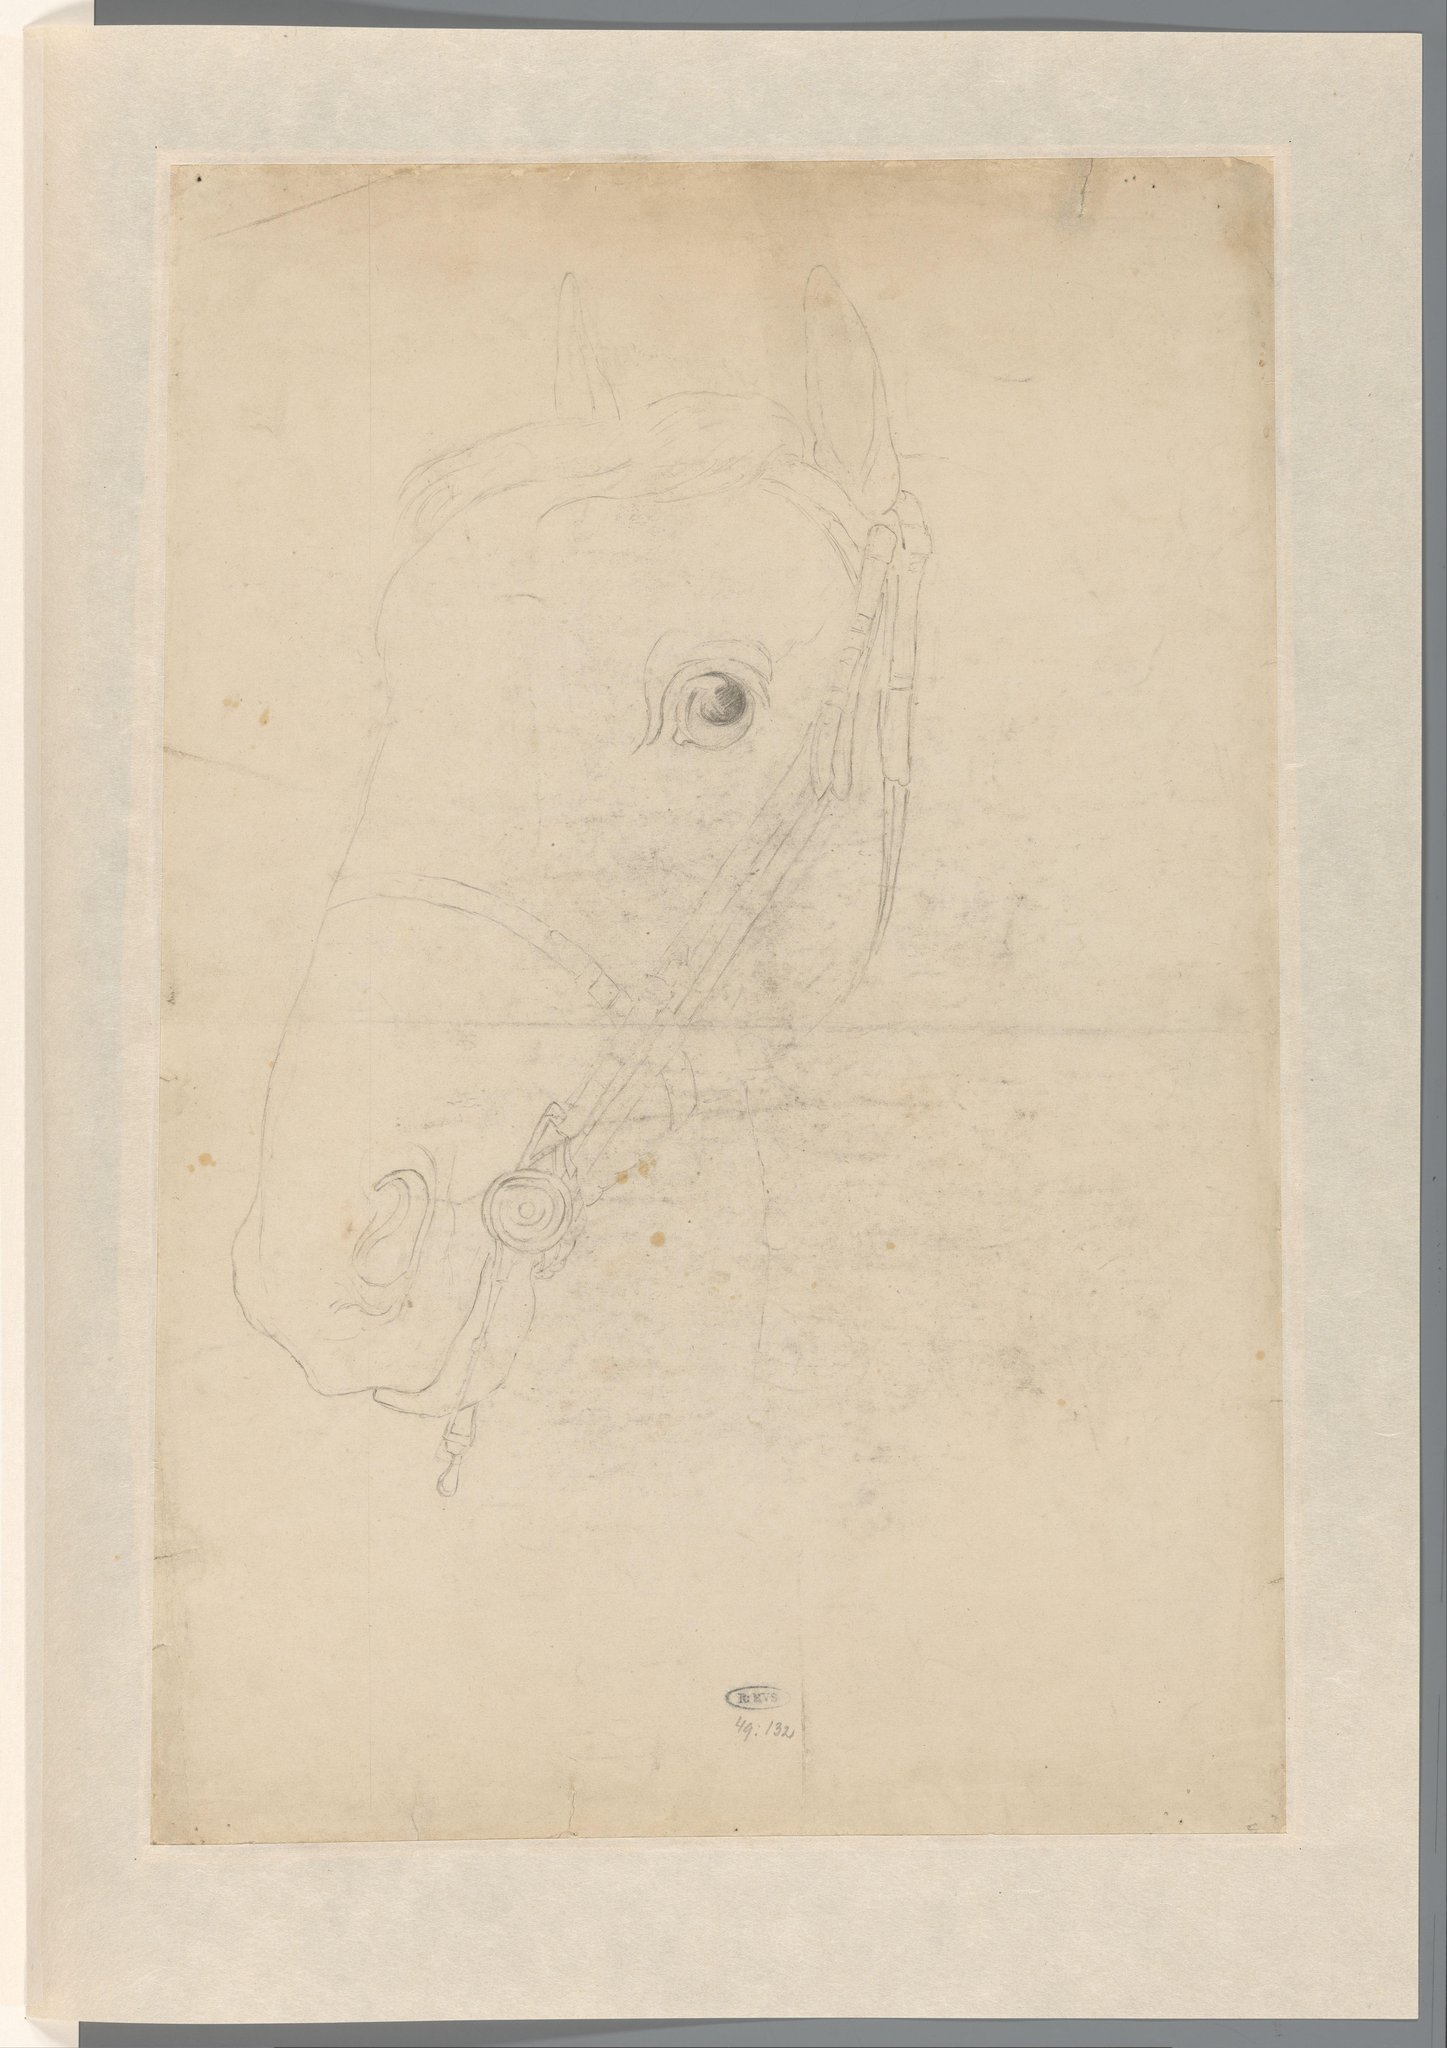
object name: drawing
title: Hoofd van een paard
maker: george hendrik breitner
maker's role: draughtsman, painter, print maker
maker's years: 1857-1923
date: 1808-1872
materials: chalk, paper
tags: horse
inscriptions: date